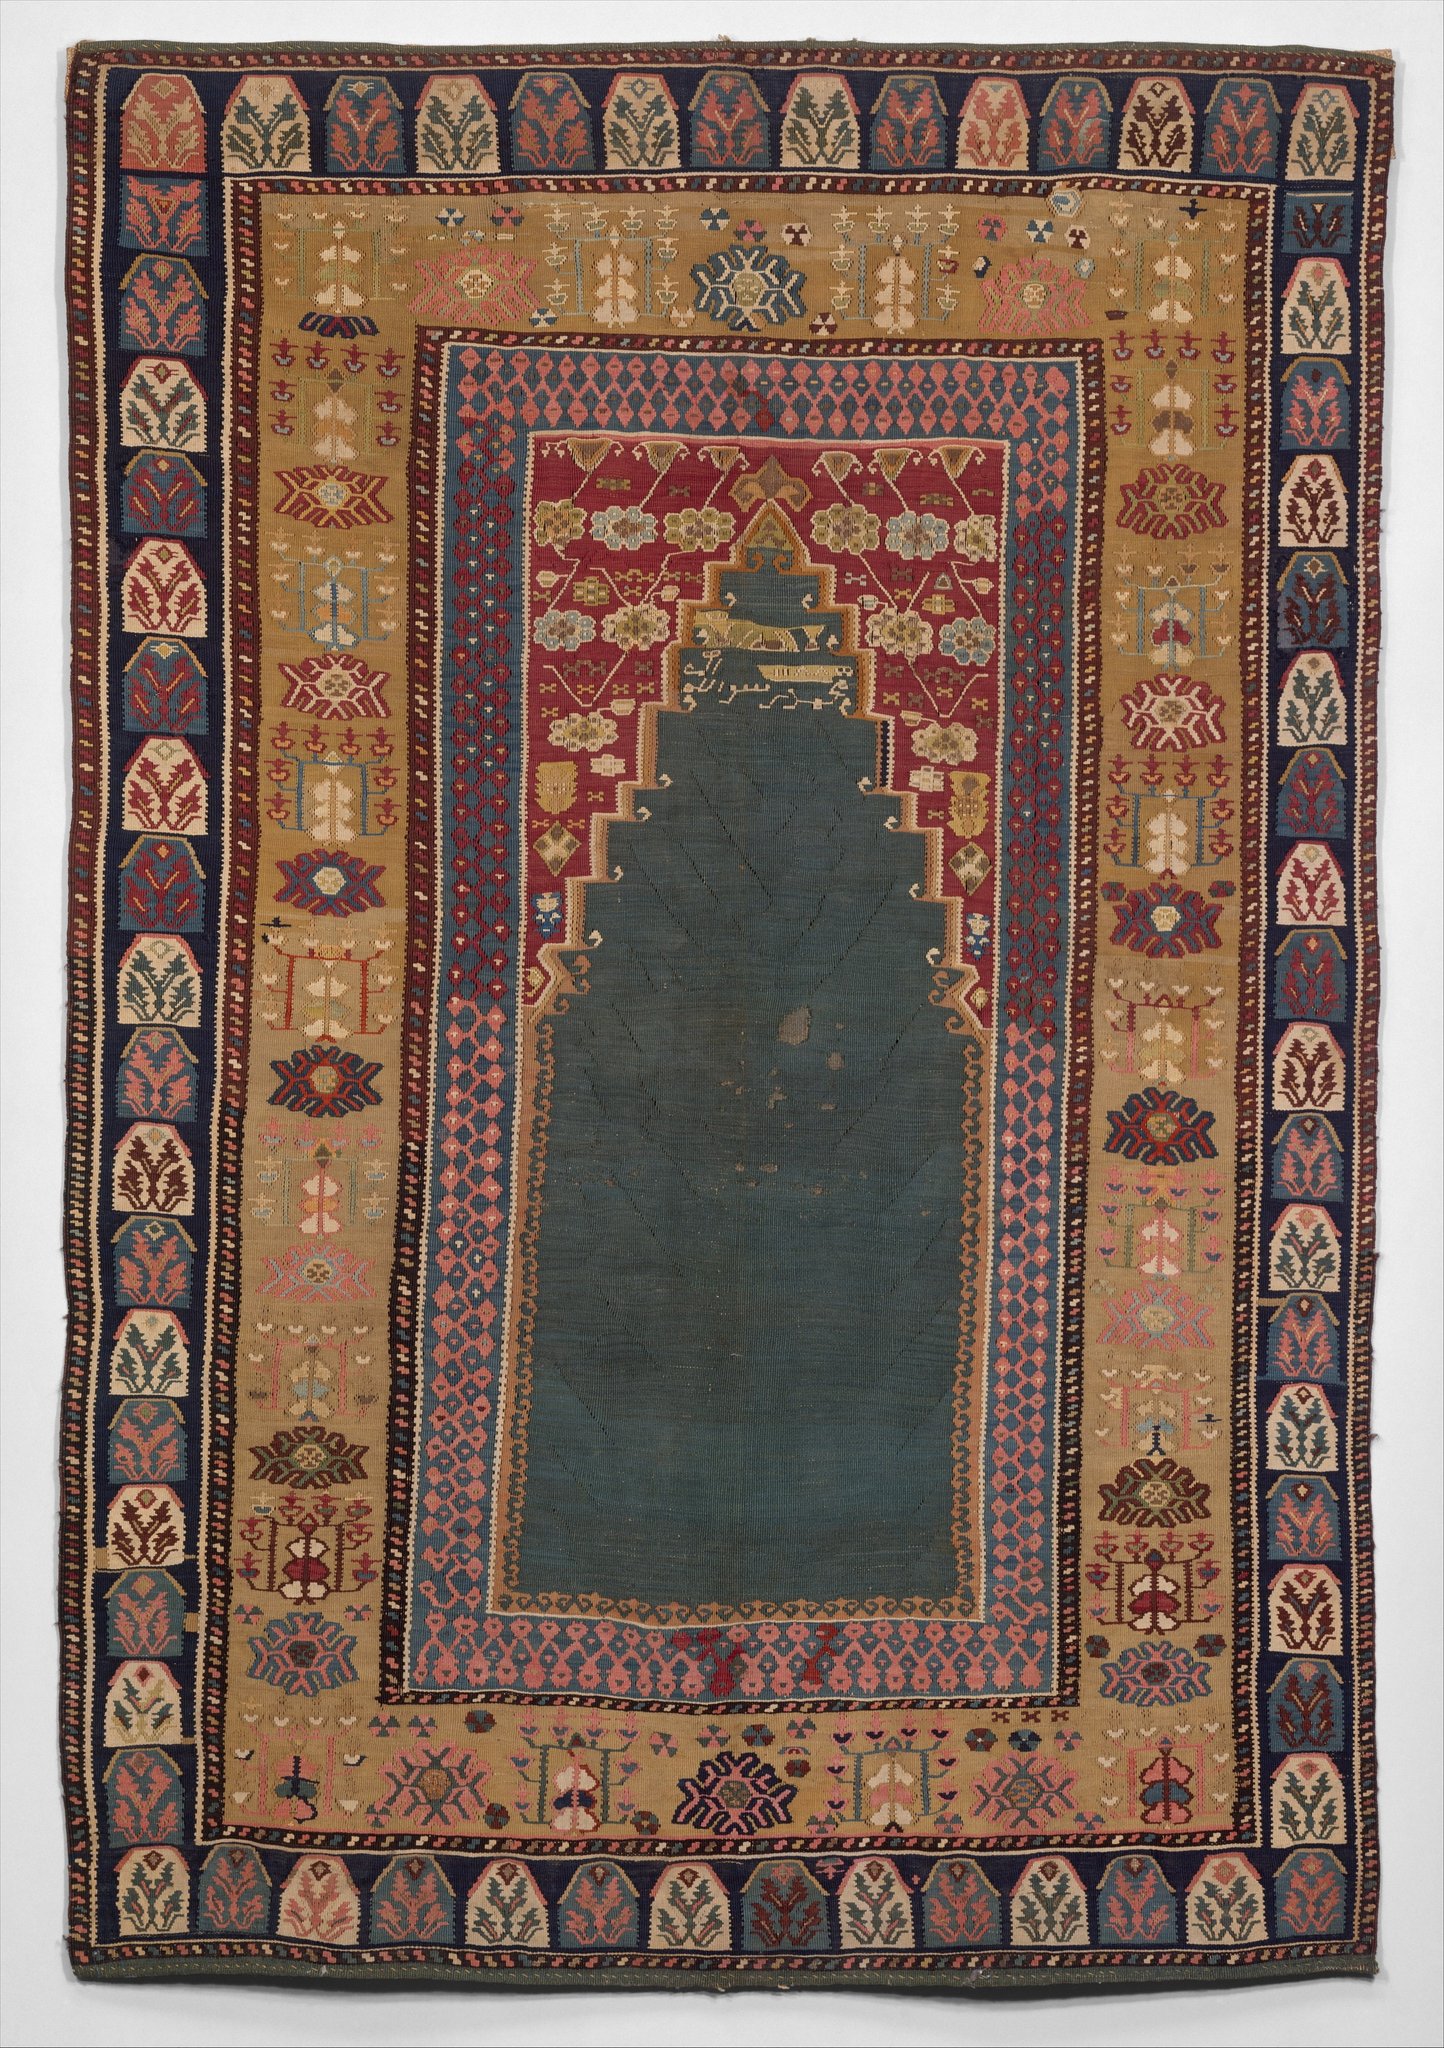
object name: carpet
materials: cotton, metal, silk, thread, wool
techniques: tapestry, weave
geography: turkey